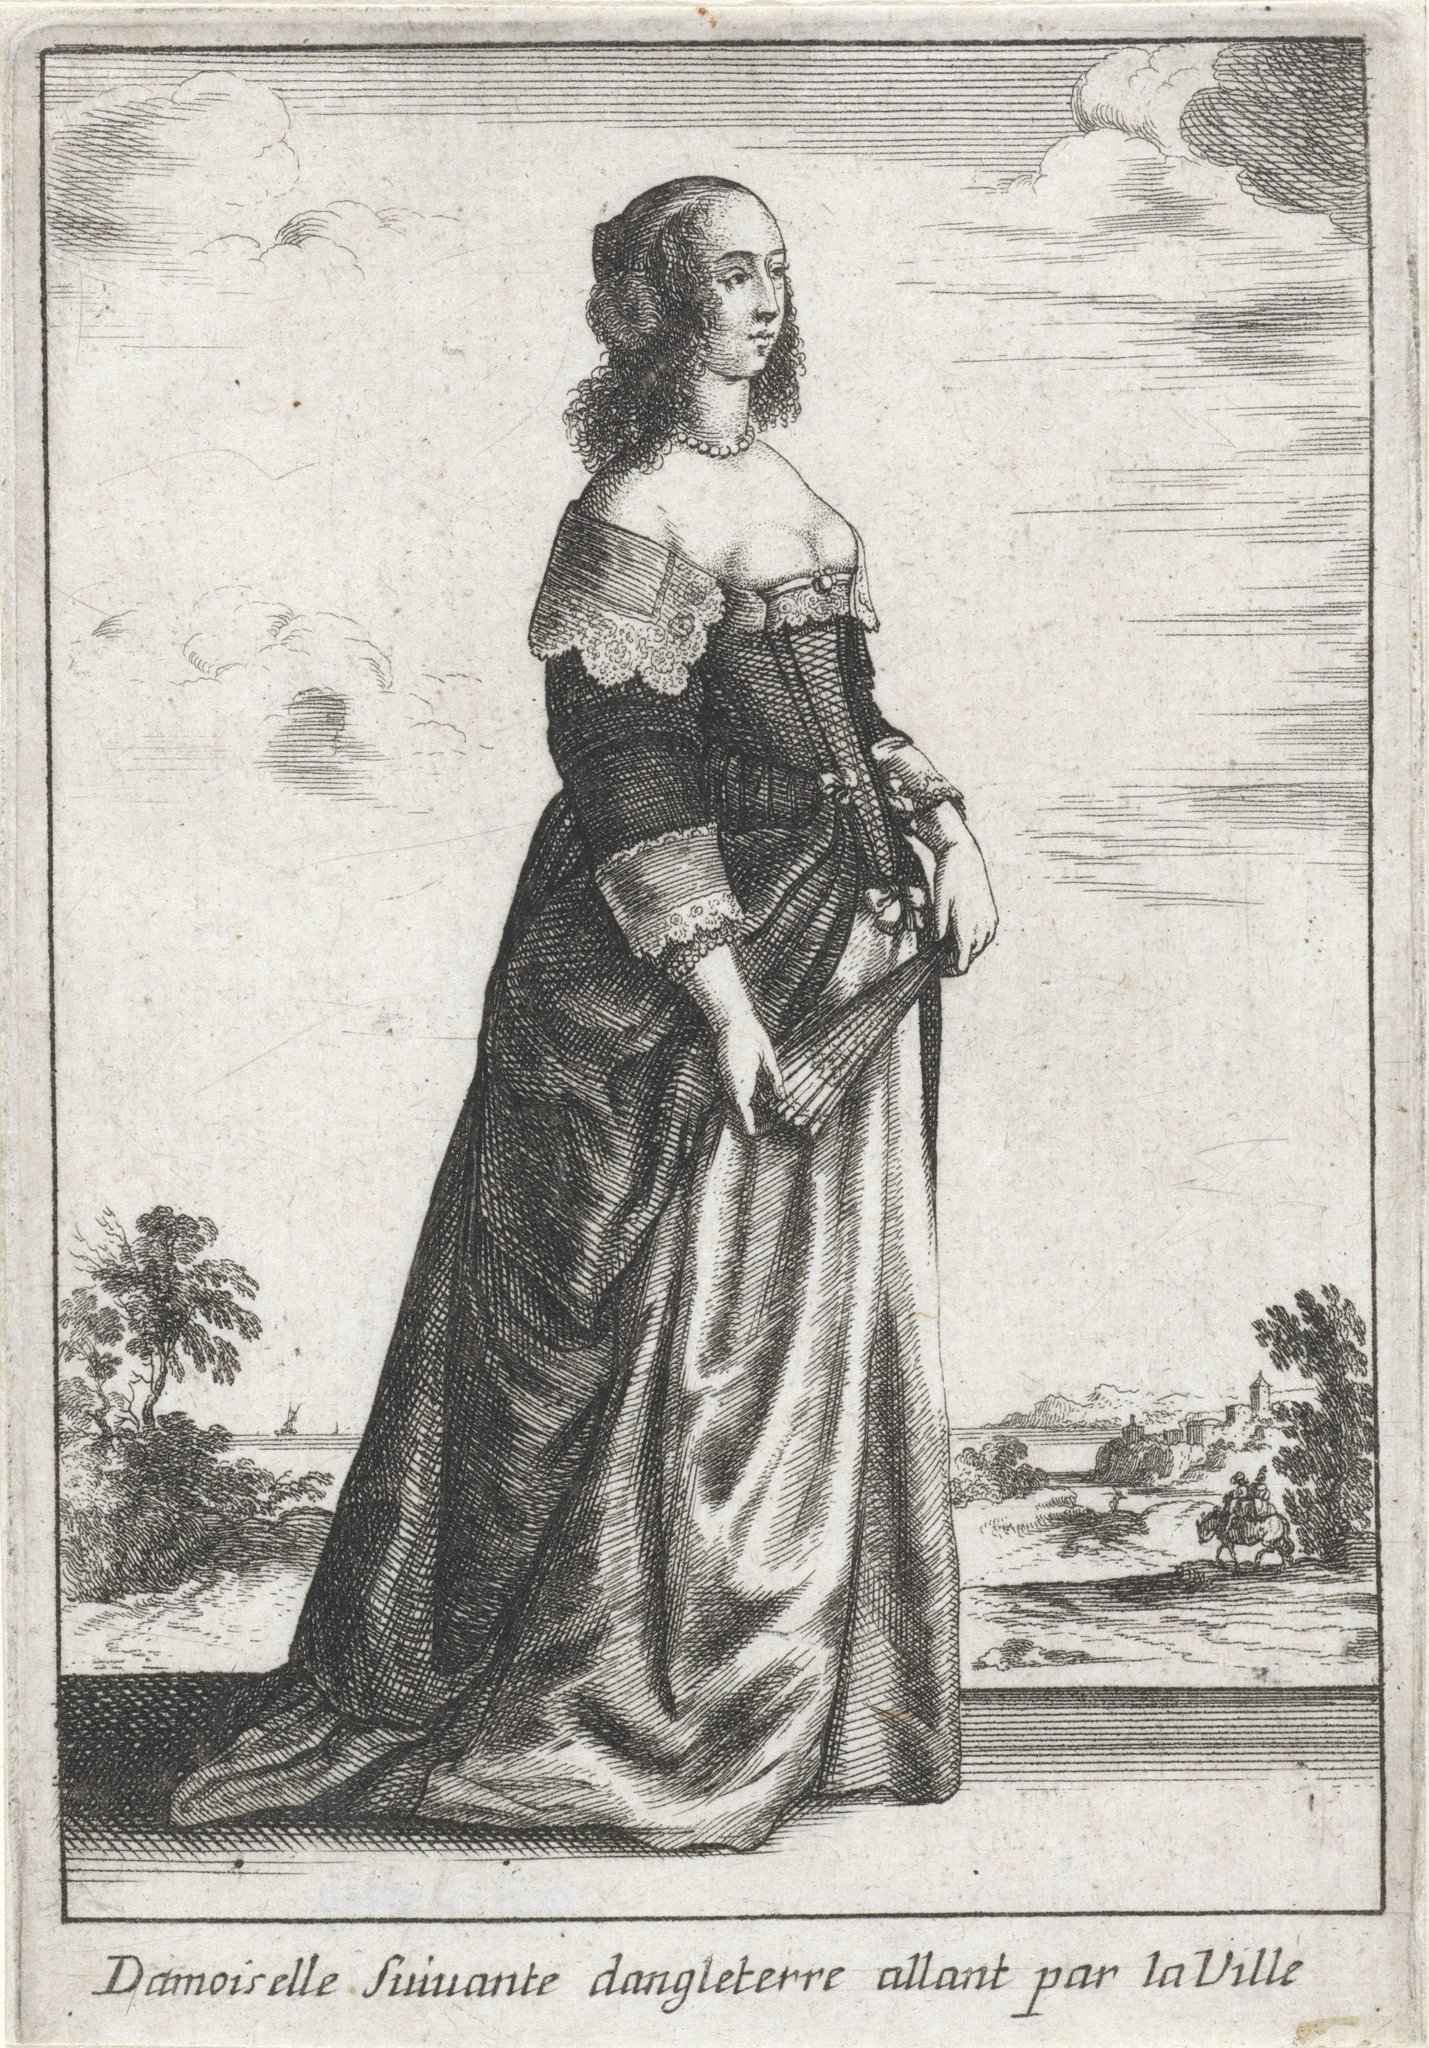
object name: costume print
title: Damoiselle Suivante dangleterre allant par la Ville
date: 1662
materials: paper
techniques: etching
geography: paris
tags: england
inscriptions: collector's mark: Lugt 240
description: Kopie naar prent die deel uitmaakt van de 50-delige serie met Europese klederdrachten, getiteld "Theatrum Mulierum".. De prent maakt deel uit van de 28-delige serie (excl. titelprent) met voorstellingen van vrouwen in verschillende klederdrachten, getiteld "Livre curieux contenant la naifue representations des habits des femmes des diverses parties du Monde (...), 1662".